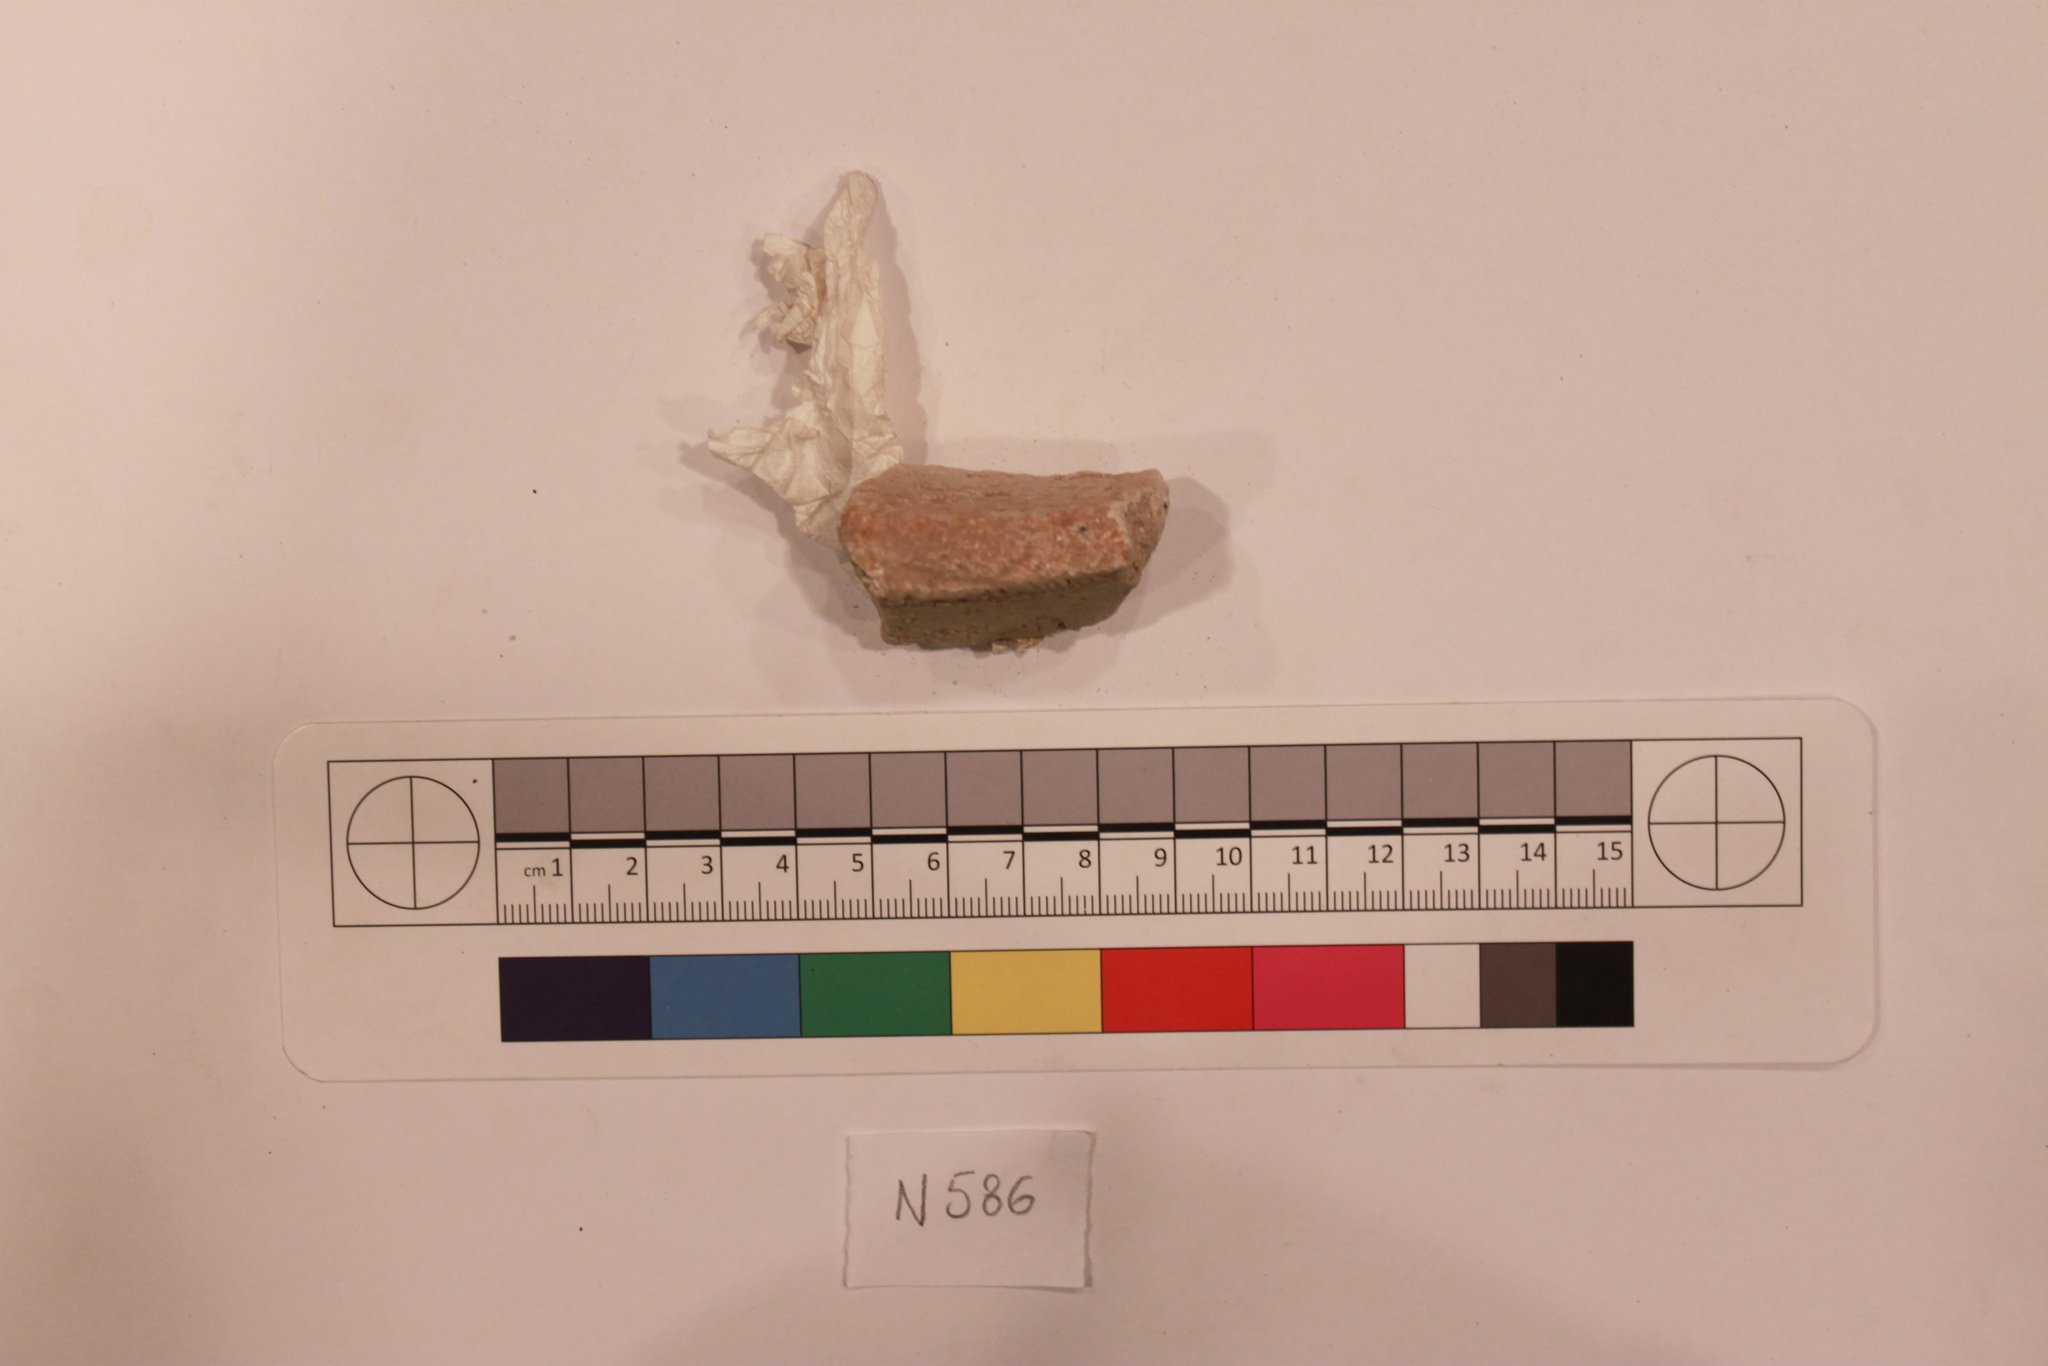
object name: fragment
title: Stucco Fragment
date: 701-1200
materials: plaster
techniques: carving, painting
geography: iran